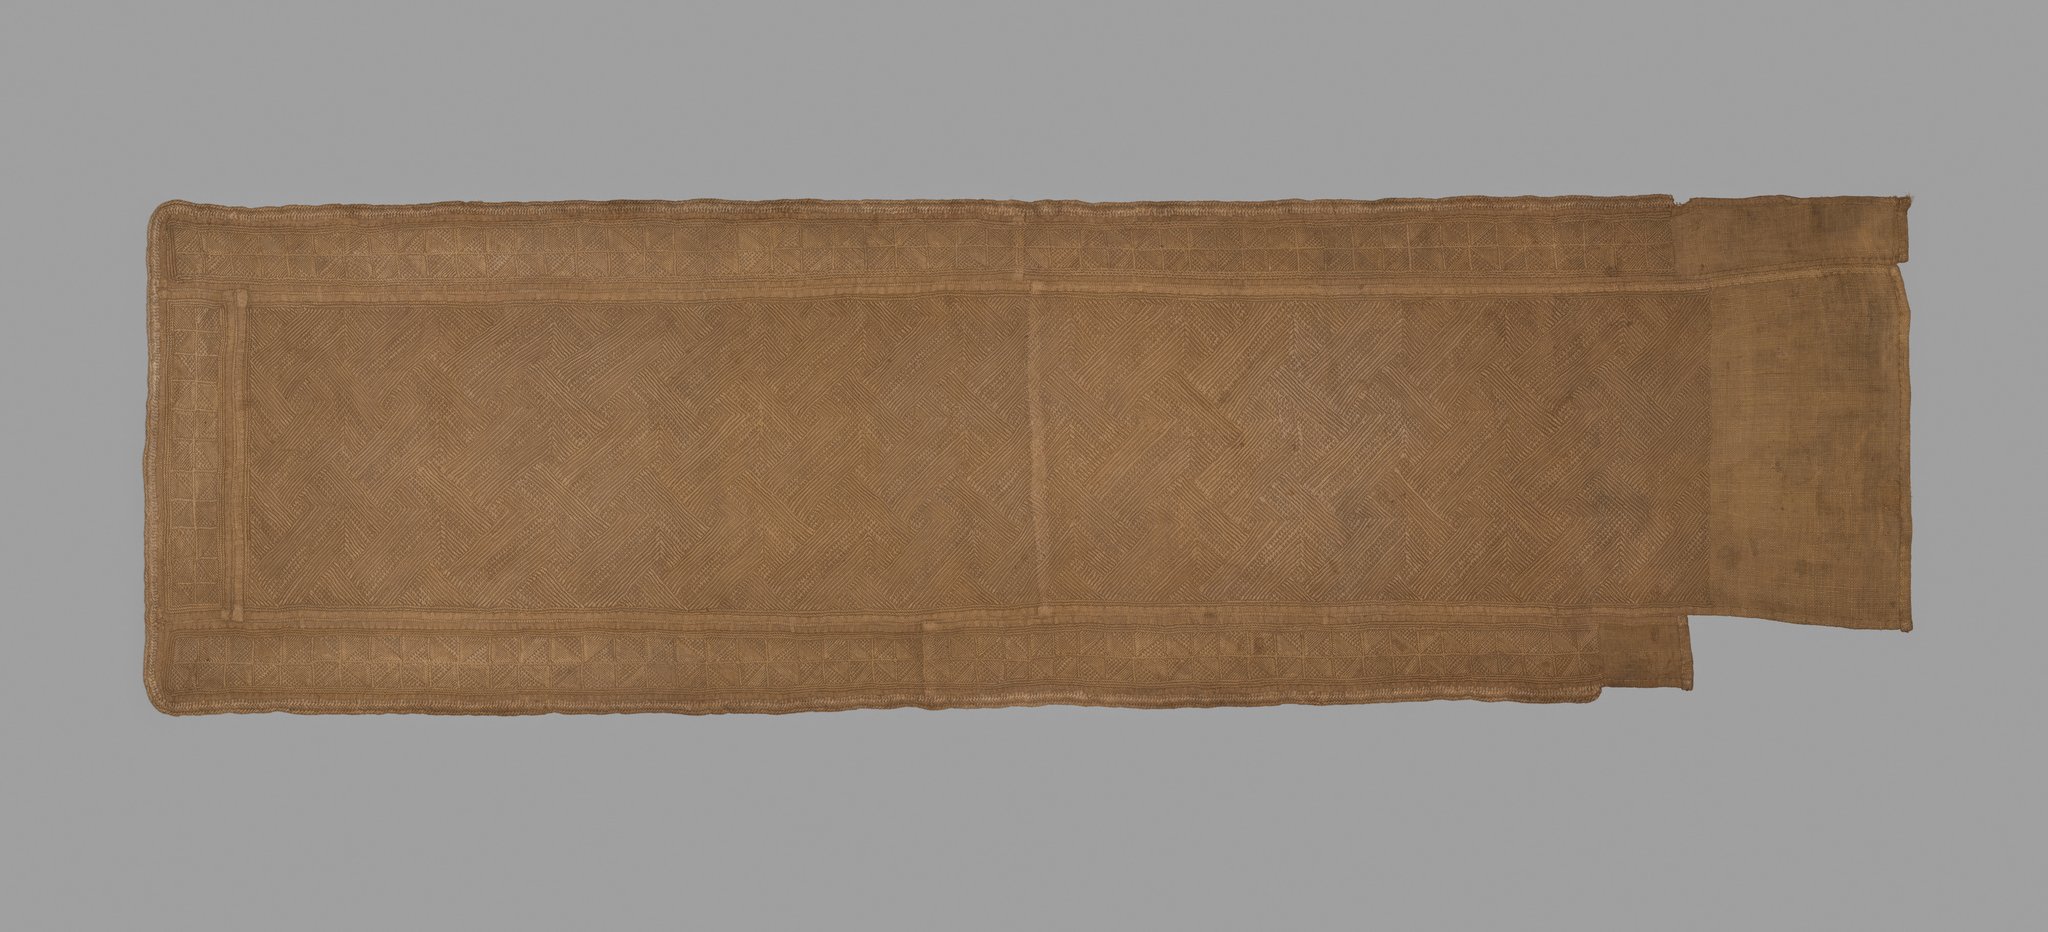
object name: overskirt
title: Women's overskirt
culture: kuba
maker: bushong-kuba artists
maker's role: artist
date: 1701-1900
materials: fiber, raffia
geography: democratic republic of the congo